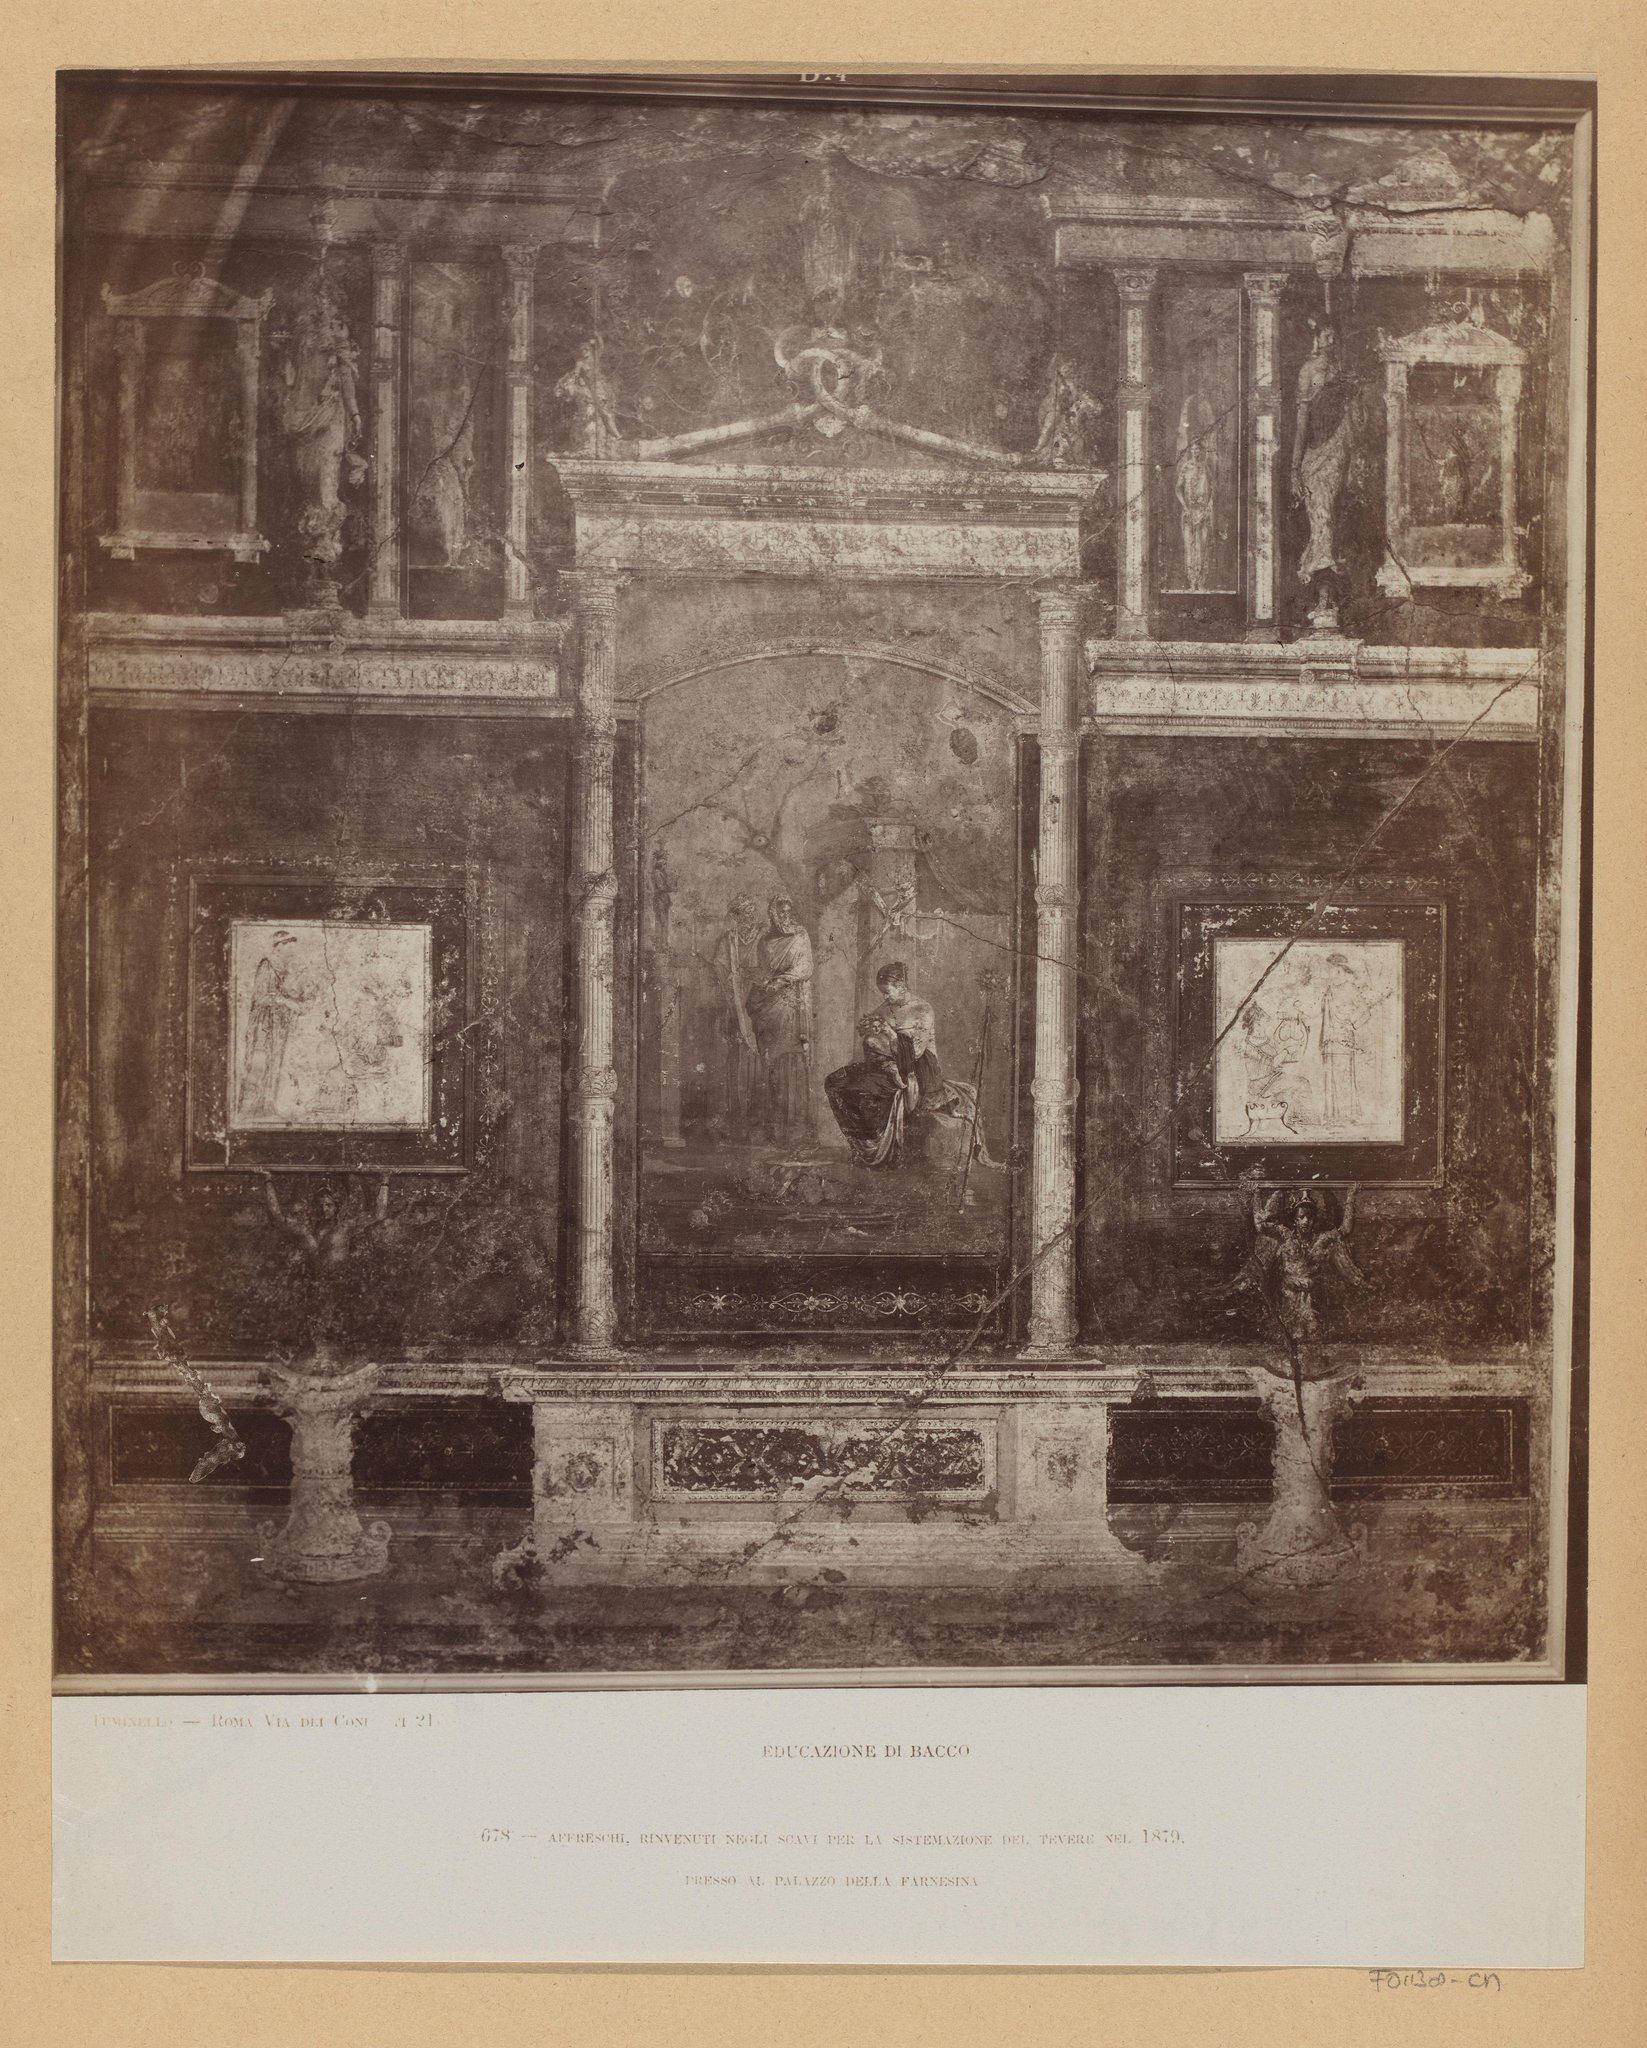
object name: photograph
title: Fotoreproductie van een fresco, voorstellend de Opvoeding van Bacchus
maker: ludovico tuminello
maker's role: fotograaf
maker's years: 1824-1907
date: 1879-1900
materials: photographic support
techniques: albumen print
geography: italy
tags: (story of) bacchus (dionysus), liber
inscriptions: address: ‘Roma Via dei Coni[...] 21’, number: ‘678’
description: Onderdeel van Reisalbum met opnames van kunstwerken en bezienswaardigheden in Italië, Griekenland en Frankrijk.